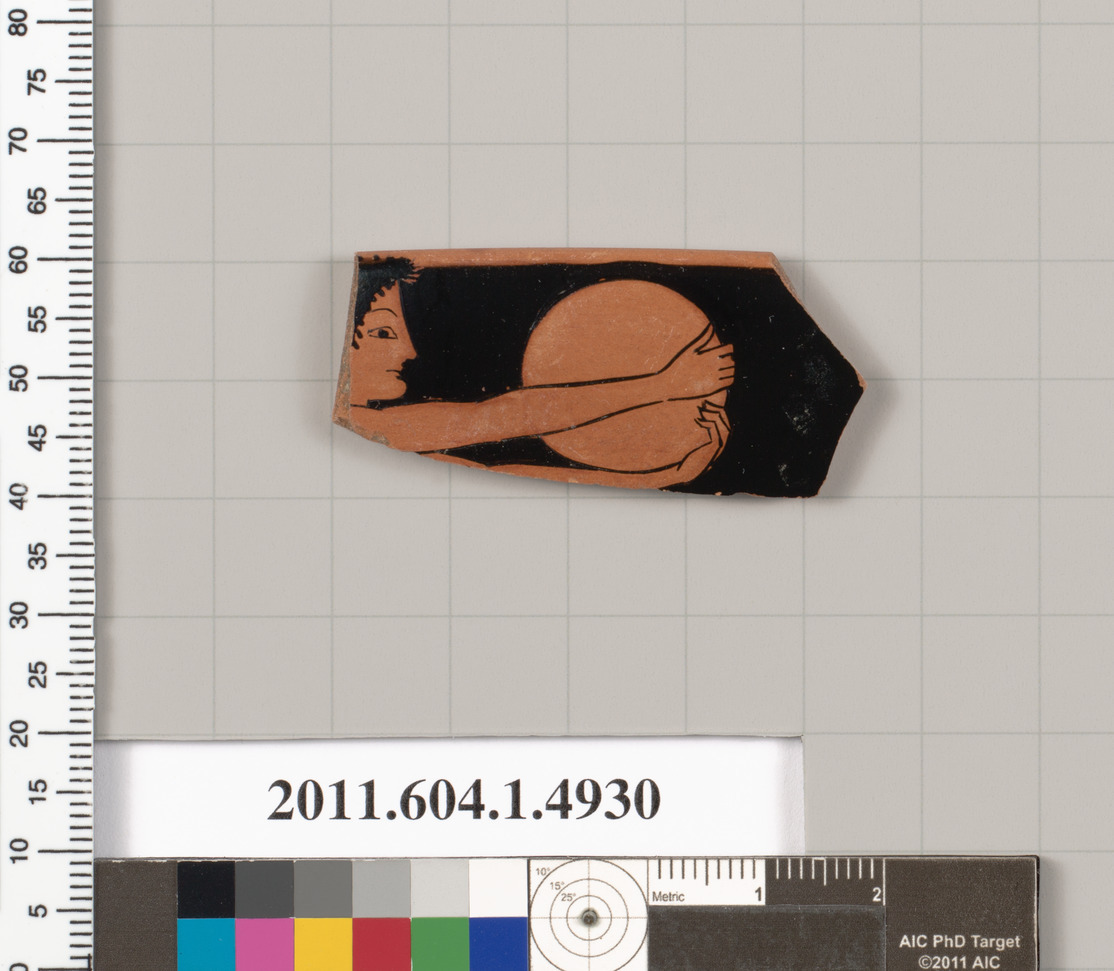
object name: kylix fragment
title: Terracotta rim fragment of a kylix (drinking cup)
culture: greek, attic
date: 520-510 BCE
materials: terracotta